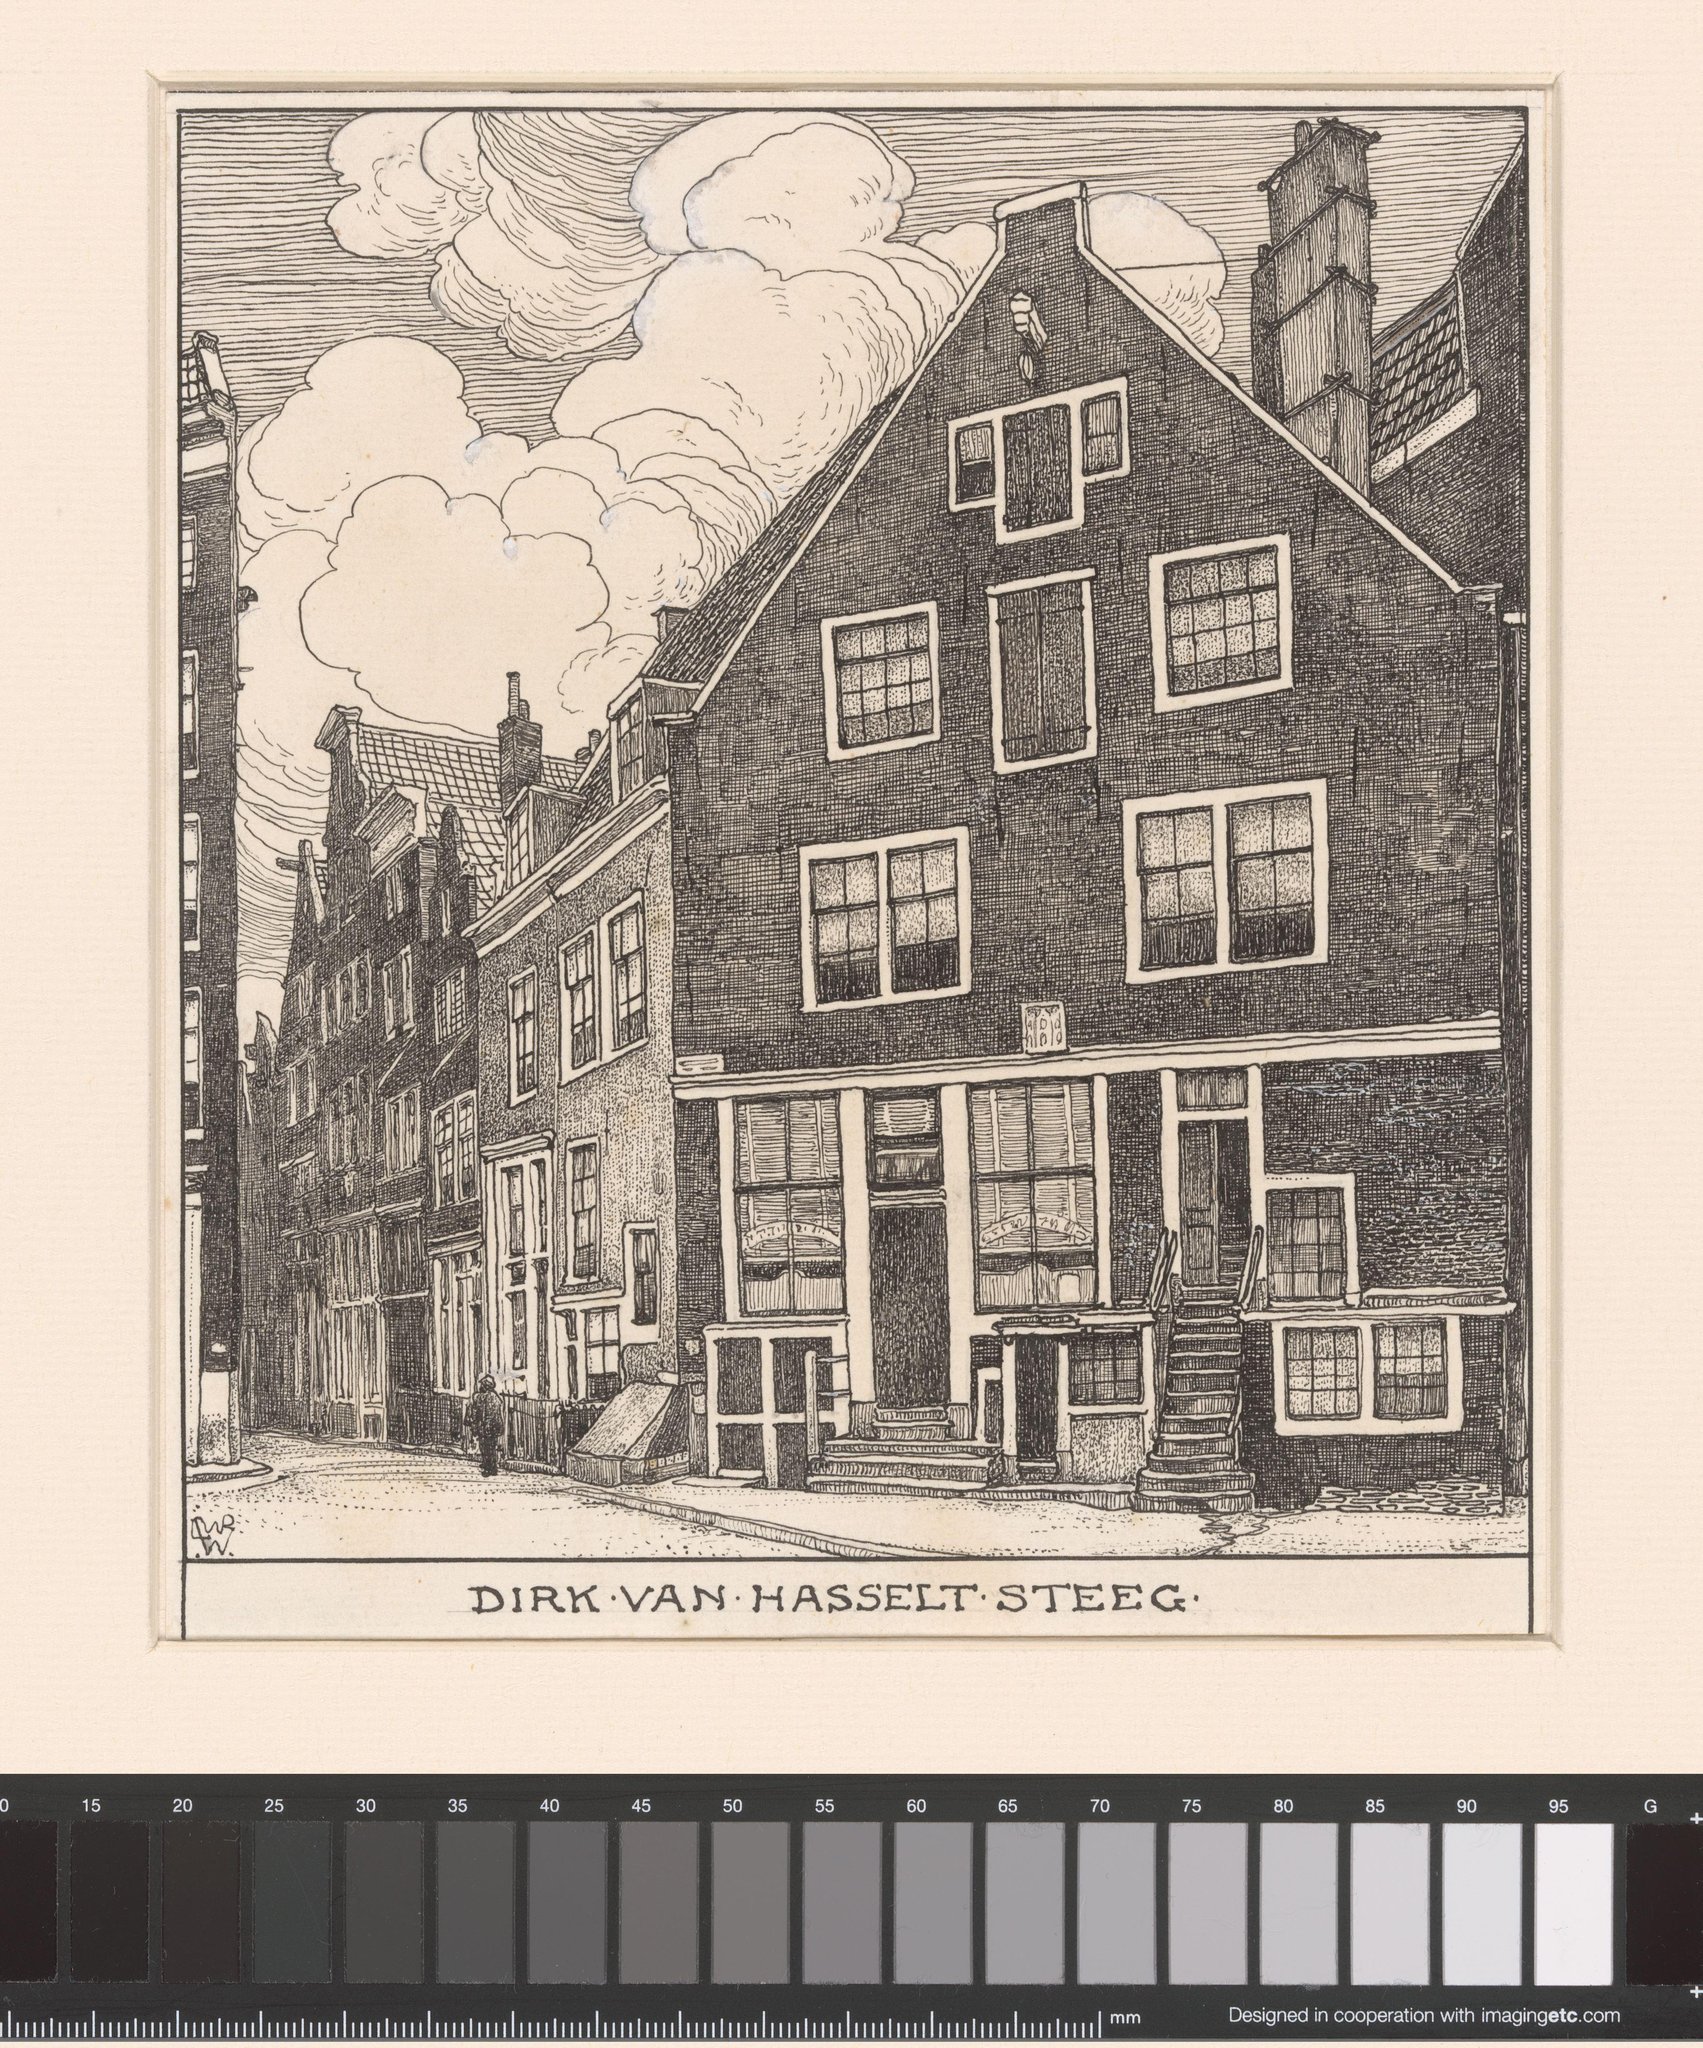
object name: drawing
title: Dirk van Hasselt Steeg te Amsterdam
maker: willem wenckebach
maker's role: designer, draughtsman, painter, print maker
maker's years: 1860-1937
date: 1870-1926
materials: paint, ink, paper, pencil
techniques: pen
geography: amsterdam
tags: lane, alley, amsterdam